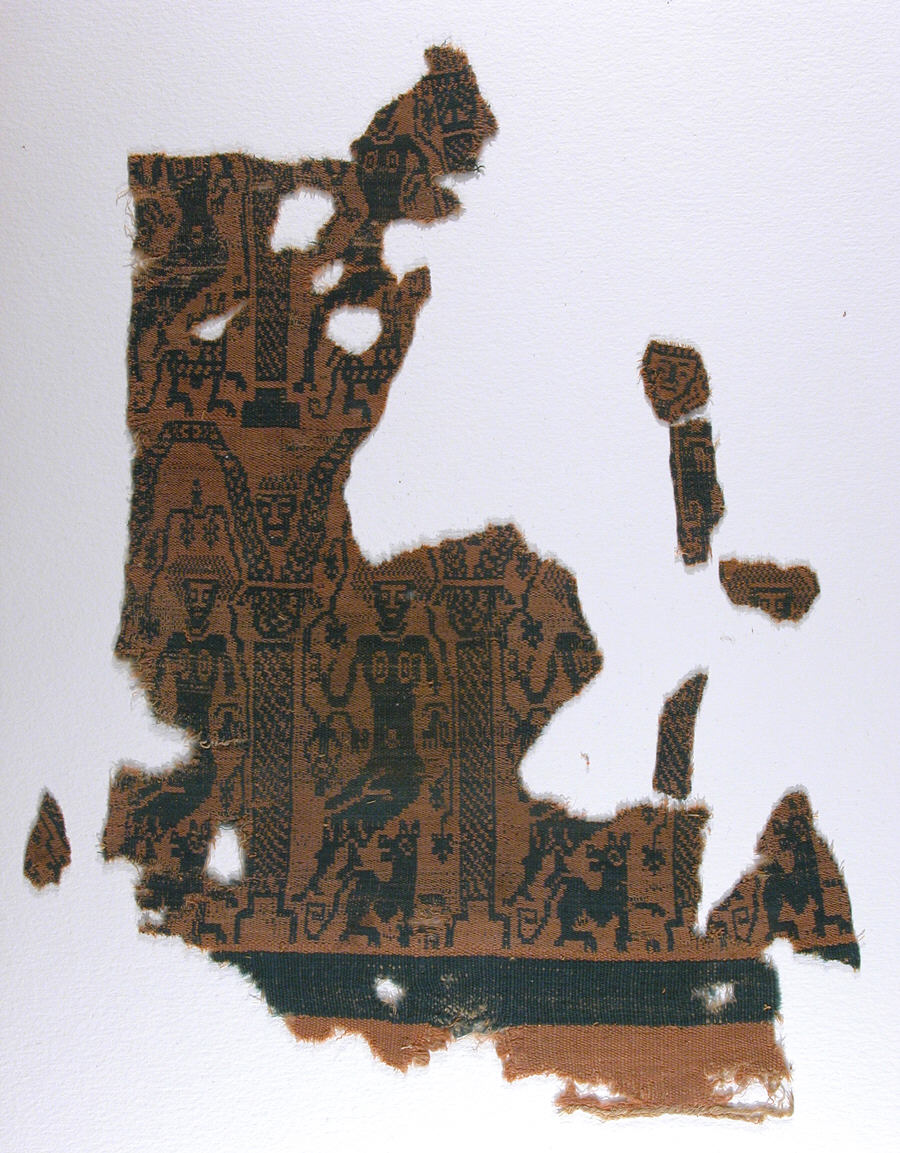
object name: fragment of a hanging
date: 401-500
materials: wool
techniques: tapestry, weave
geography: egypt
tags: human figures,animals